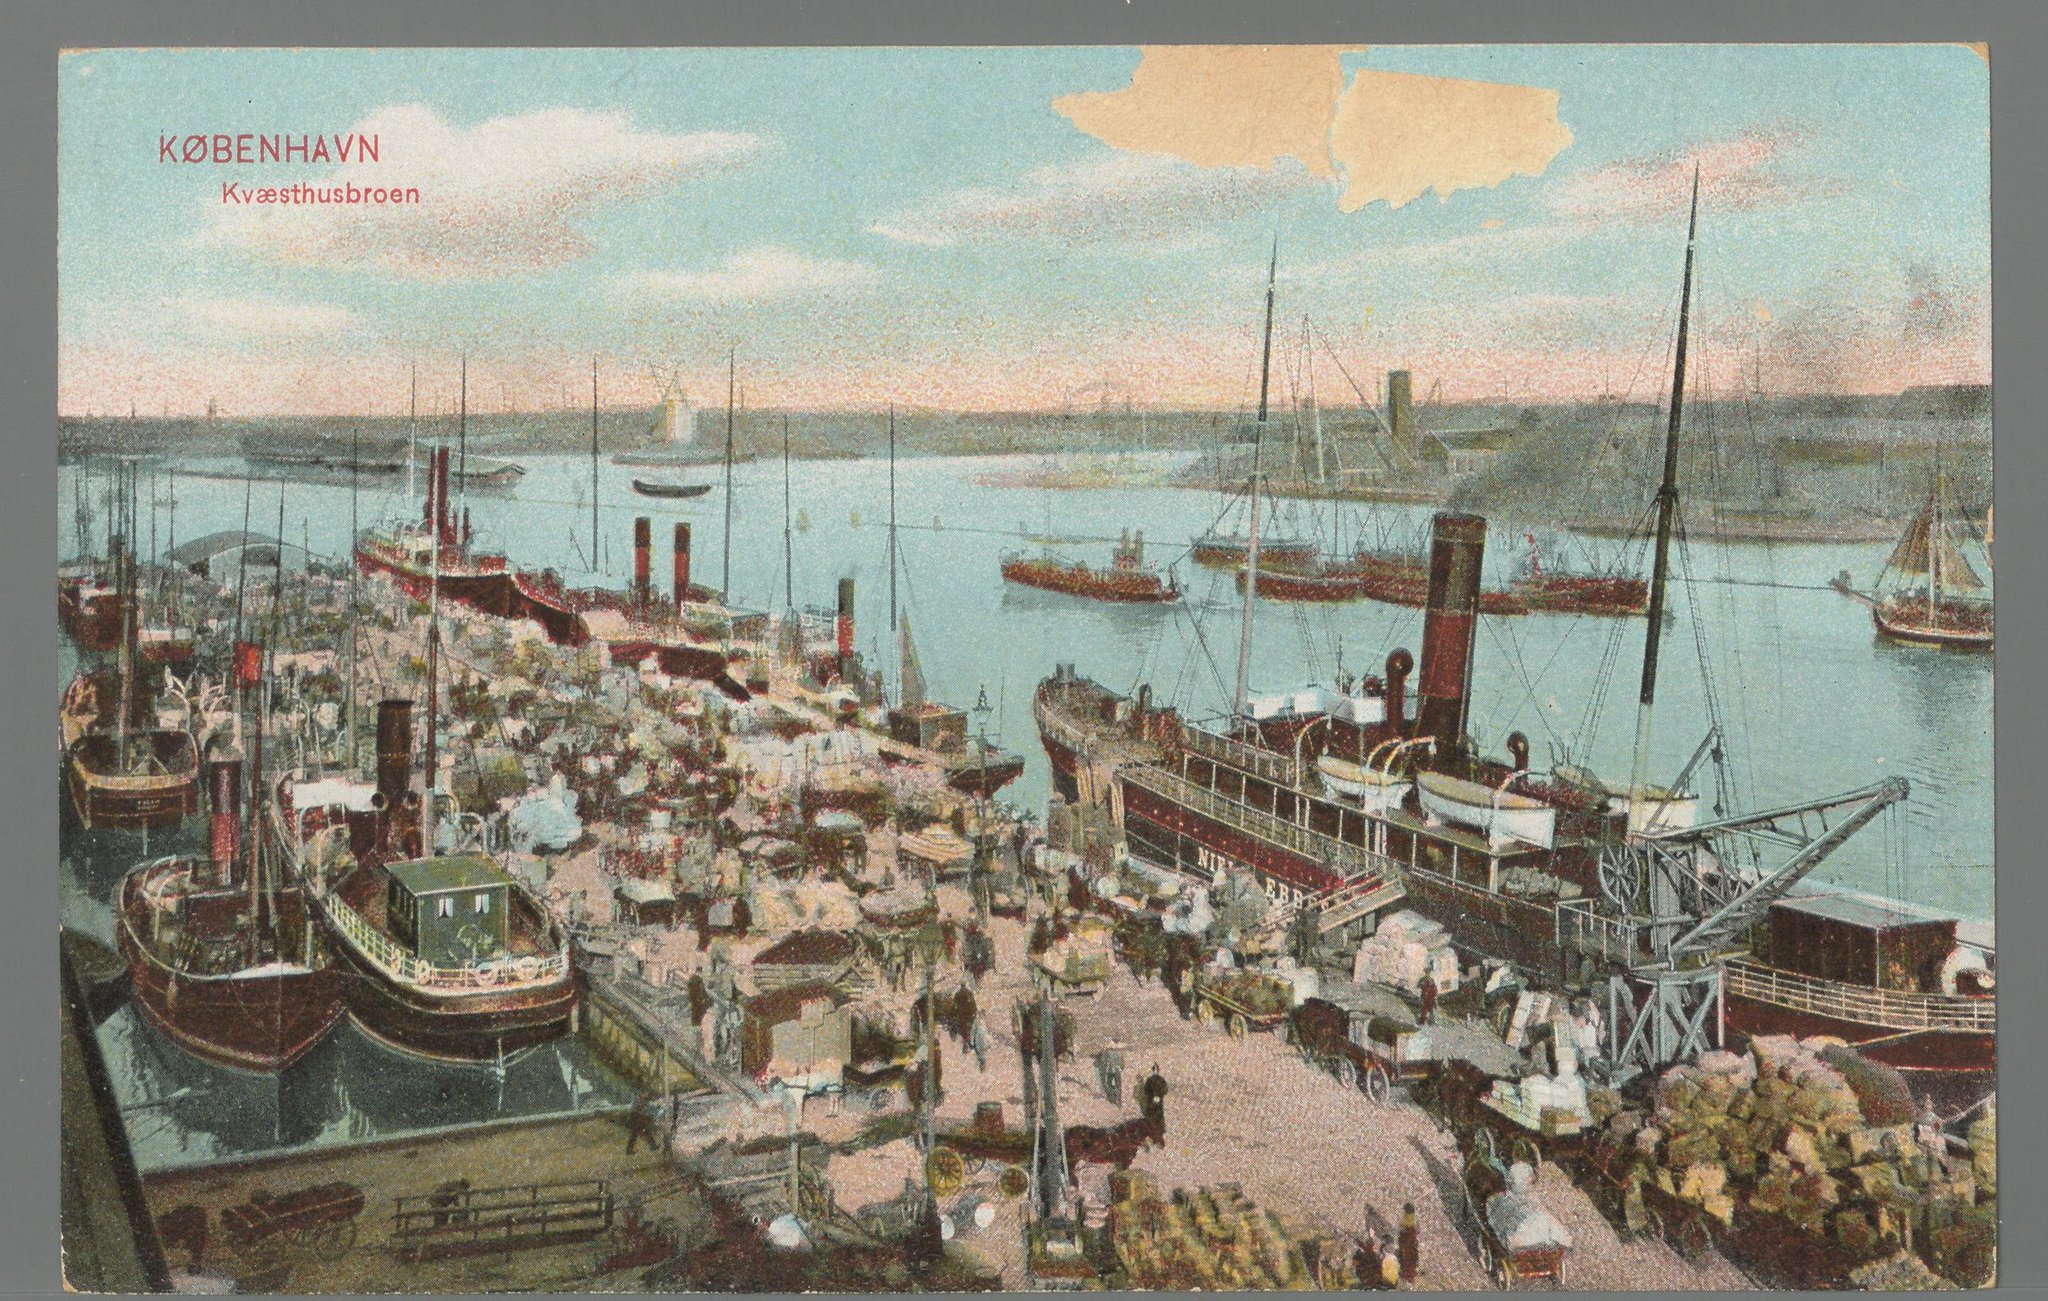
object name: photomechanical print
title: København. Kvaesthusbroen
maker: Anonymous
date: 1906-1920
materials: cardboard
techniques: lithograph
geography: copenhagen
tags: harbour, ships (in general), copenhagen (city)